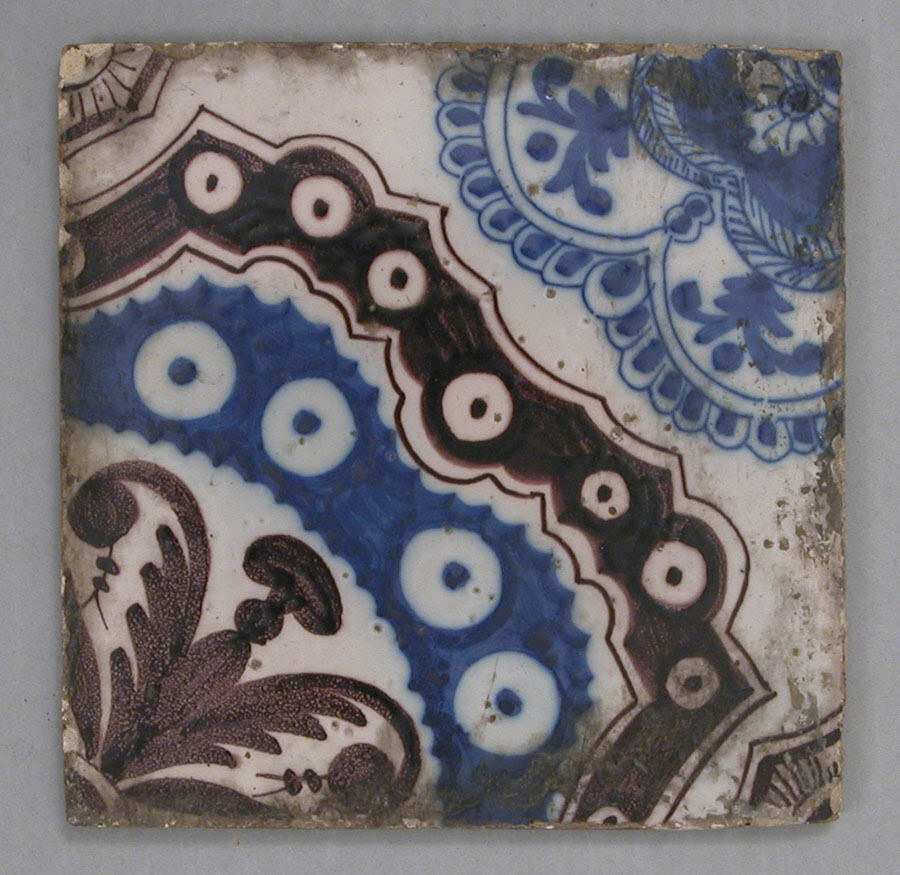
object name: tile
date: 1701-1800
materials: stonepaste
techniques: glazing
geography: north africa